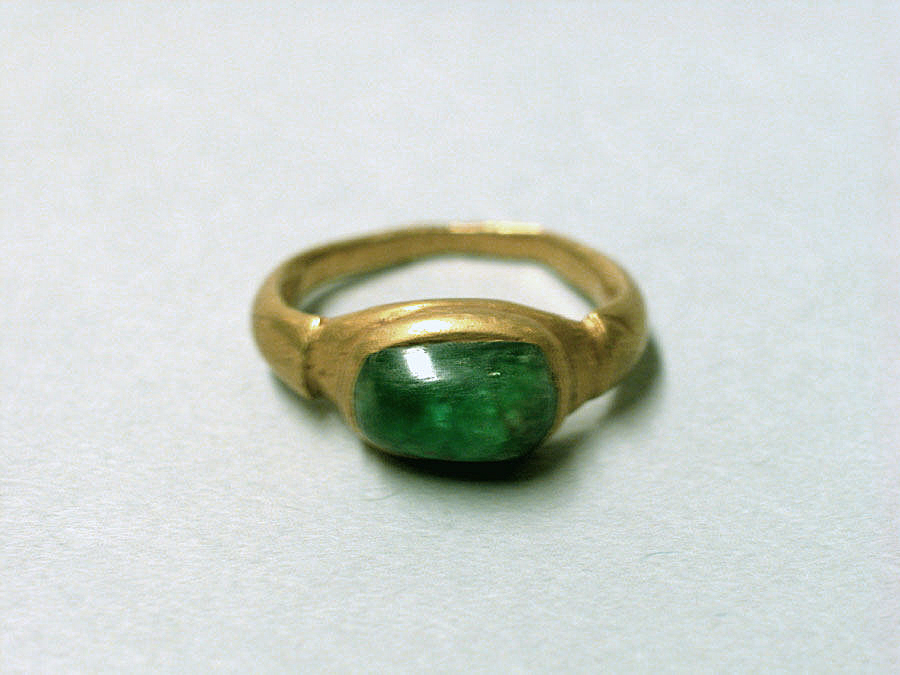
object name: ring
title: Gold and beryl ring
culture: roman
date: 167-300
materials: gold